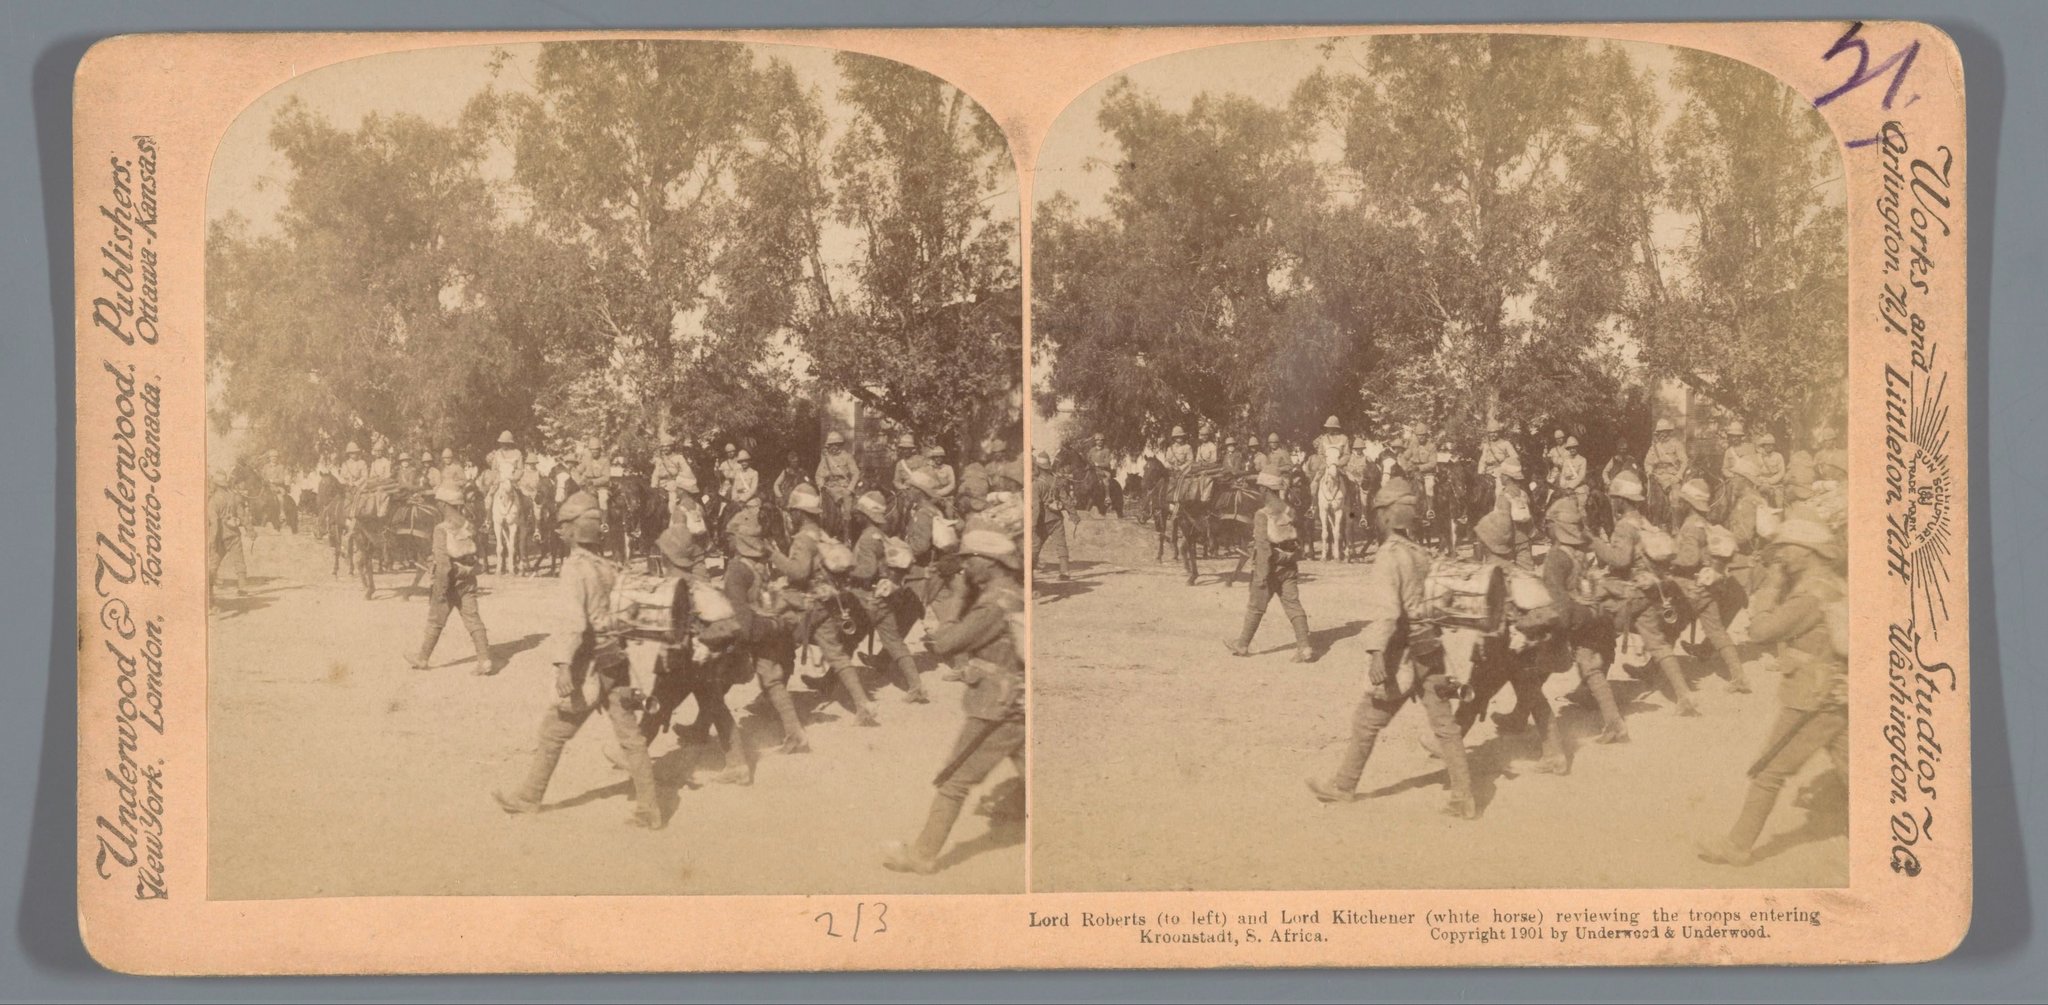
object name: stereograph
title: Geënsceneerde voorstelling van Frederick Sleigh Roberts en Herbert Kitchener die de intocht van soldaten in Kroonstad bekijken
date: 1901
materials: cardboard, photographic support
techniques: albumen print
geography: kroonstad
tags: troop movements, transportation, the soldier; the soldier's life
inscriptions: number: ‘213’, name: ‘James H. Heyes Dec 14 1907 Clerk Little Hulton District Council’, name: ‘Works and Studios Sun Sculpture trade mark Arlington N.J. Littleton N.H. Washington D.C.’